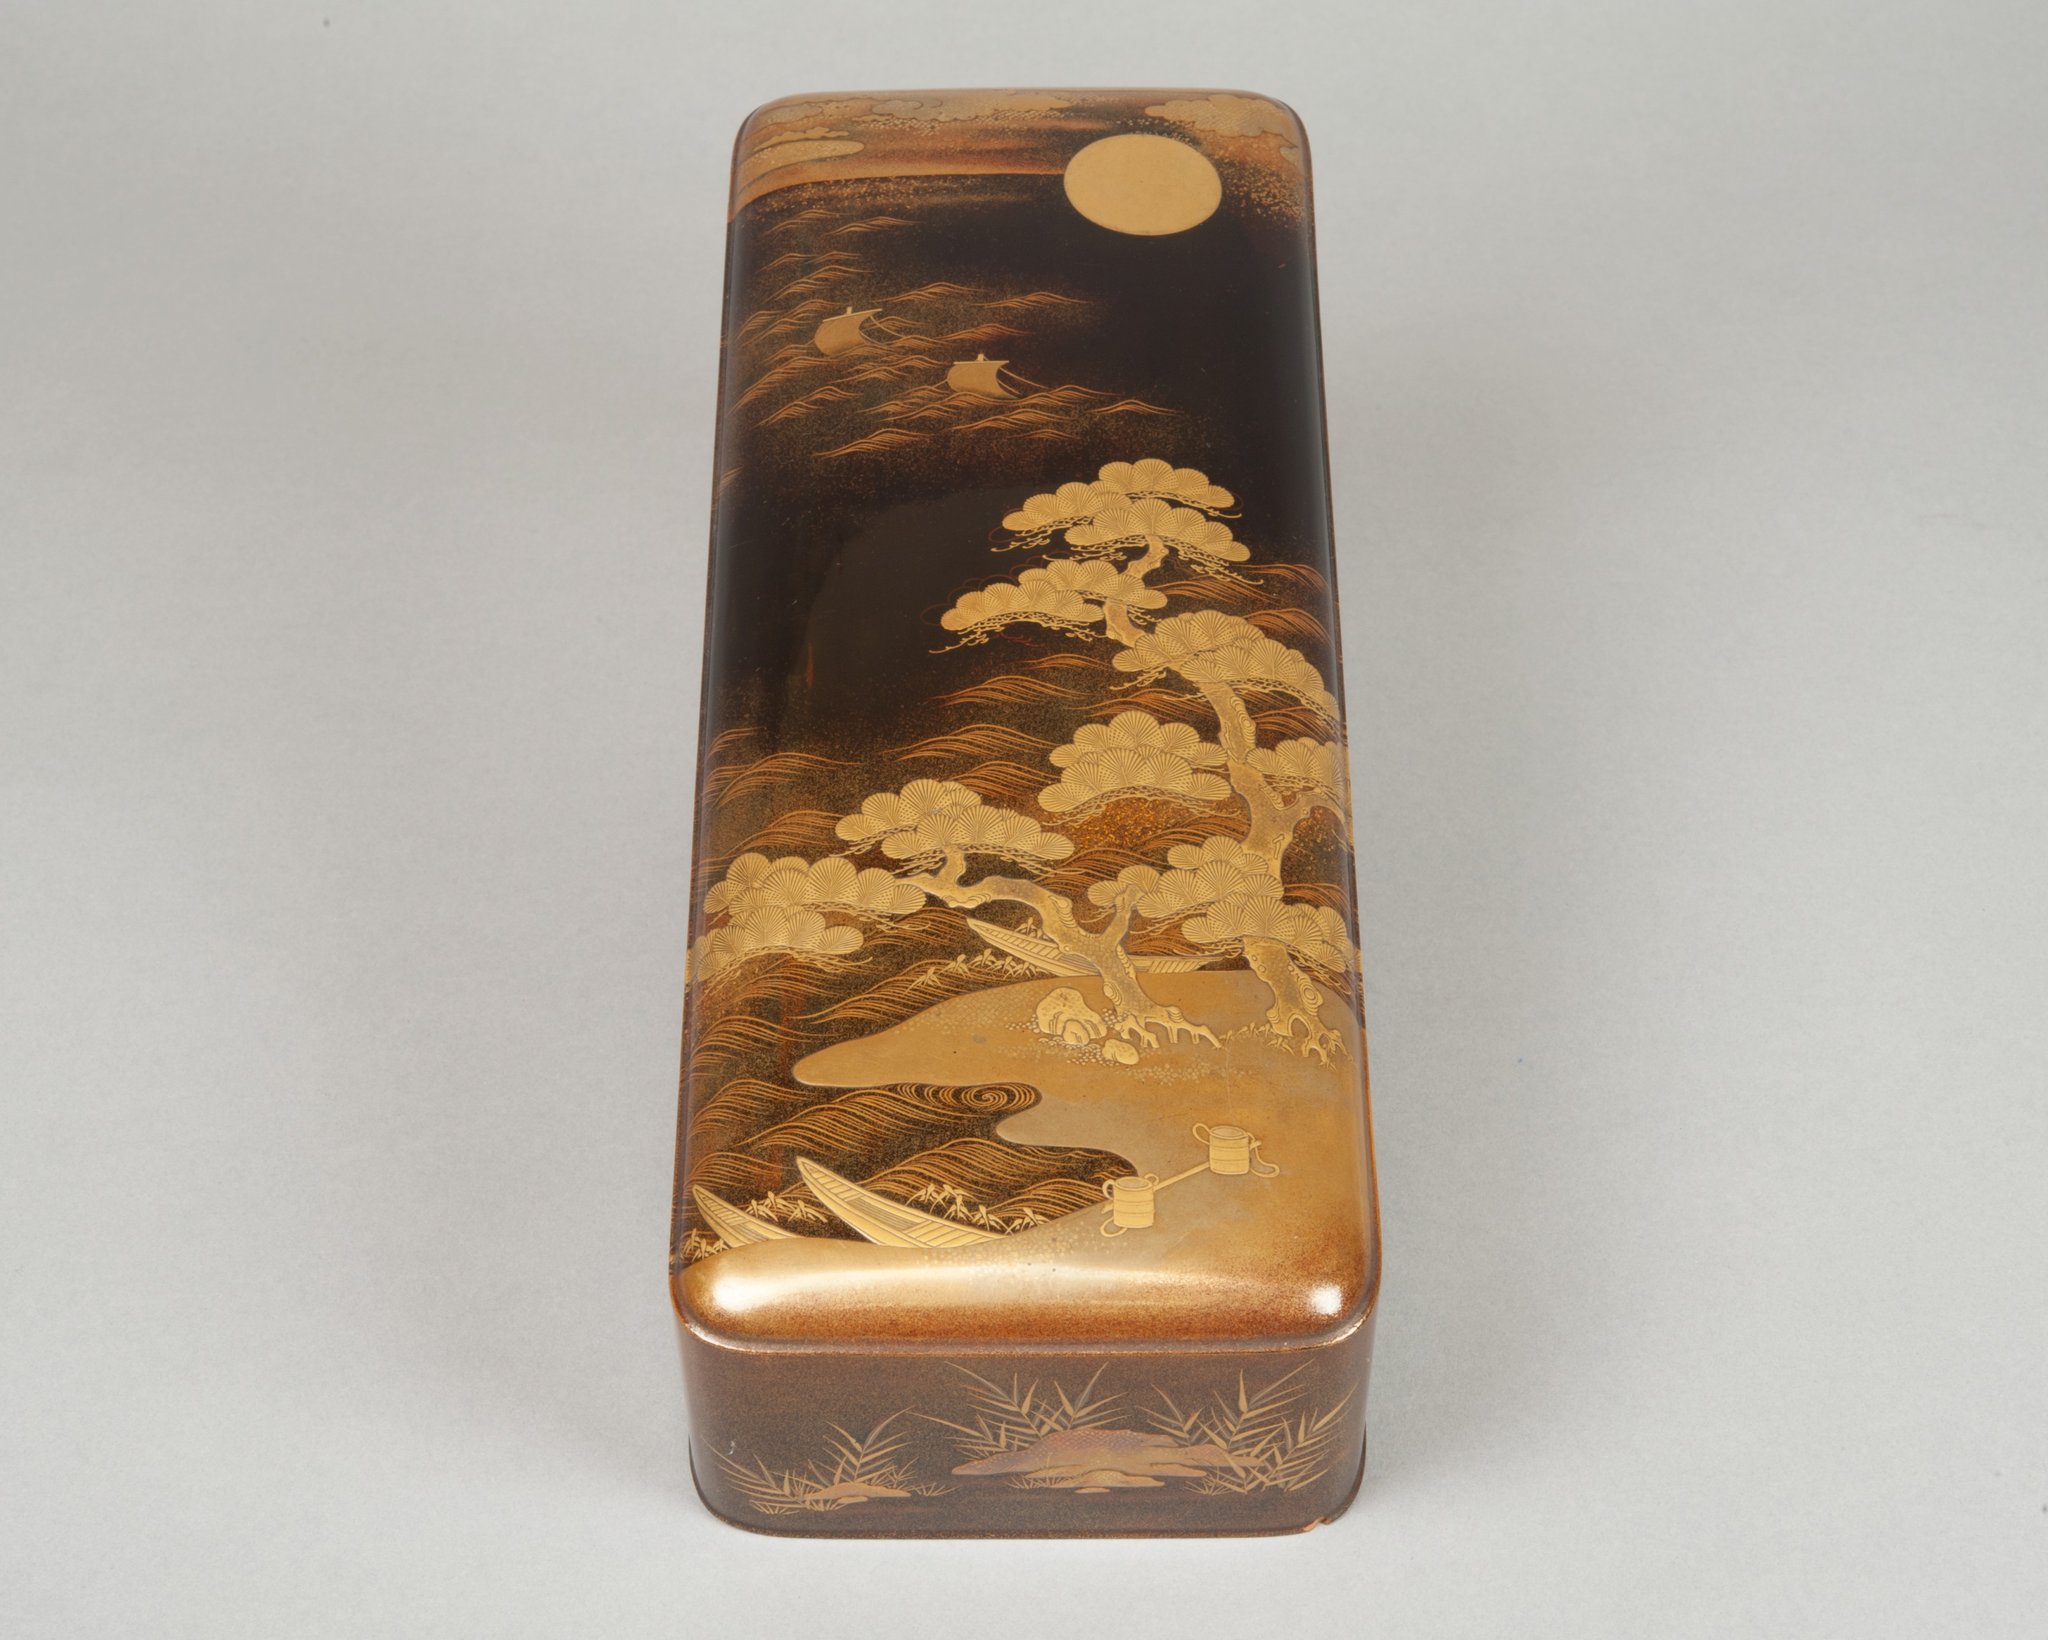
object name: letter box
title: Letter Box (Fubako) with Design of the Shore at Suma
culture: japanese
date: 1801-1900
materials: gold, lacquer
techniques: maki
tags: trees,boats